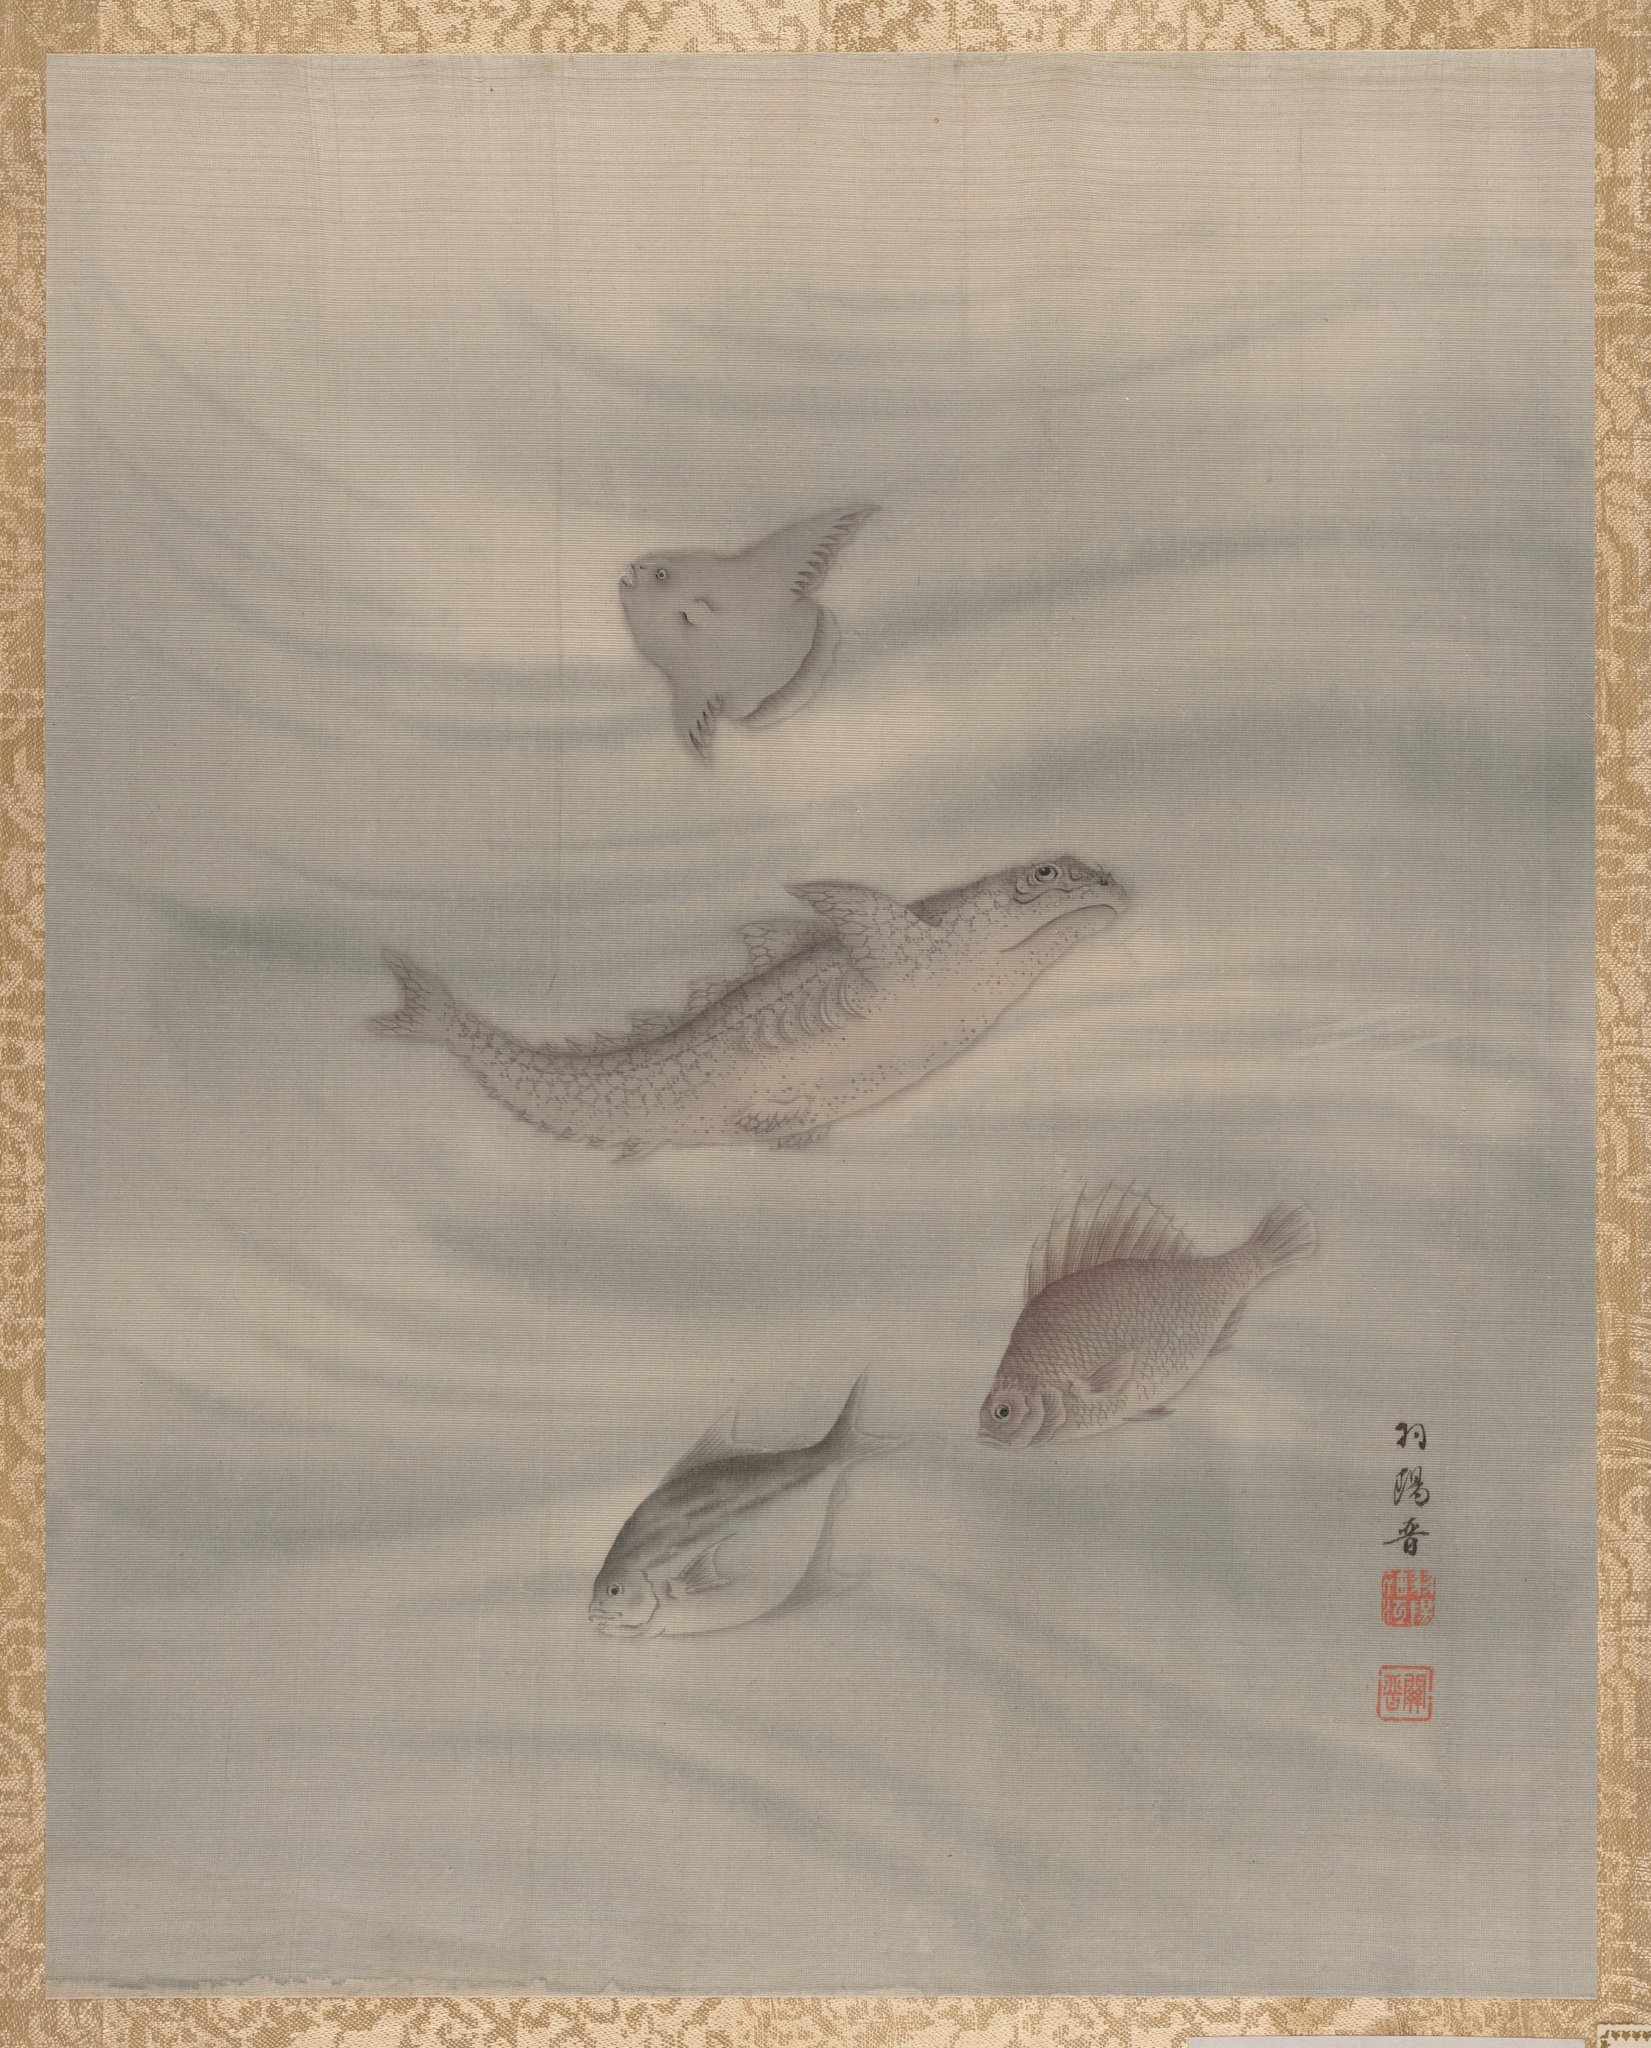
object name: album leaf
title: Fishes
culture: japanese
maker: seki shūkō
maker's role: artist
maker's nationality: japanese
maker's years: 1858-1915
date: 1890-1892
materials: silk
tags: fish